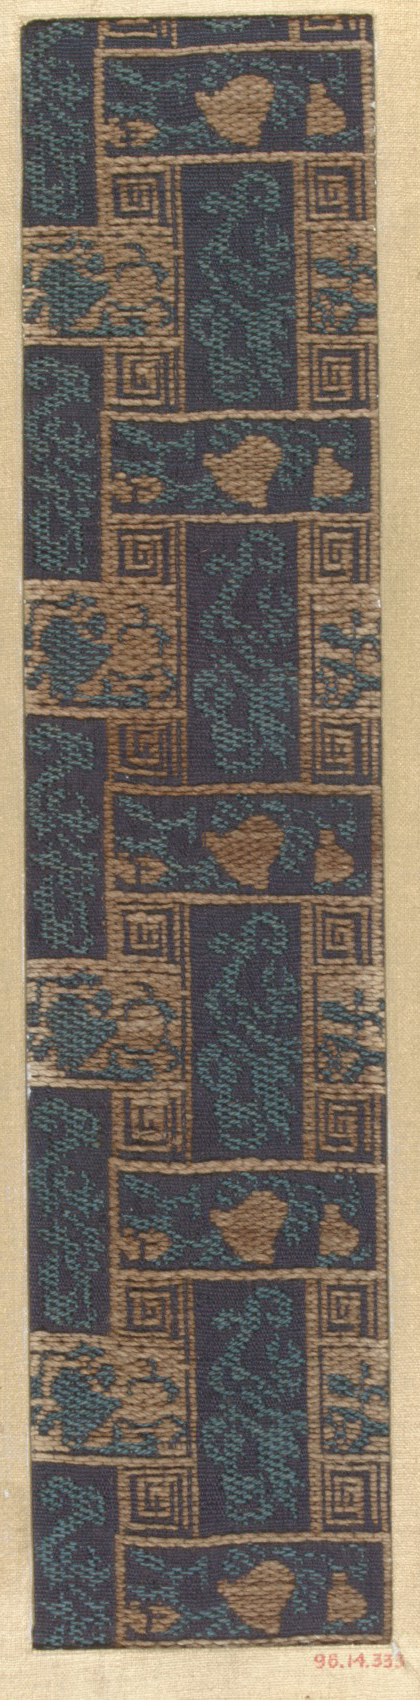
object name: piece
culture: japanese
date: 1701-1900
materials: silk